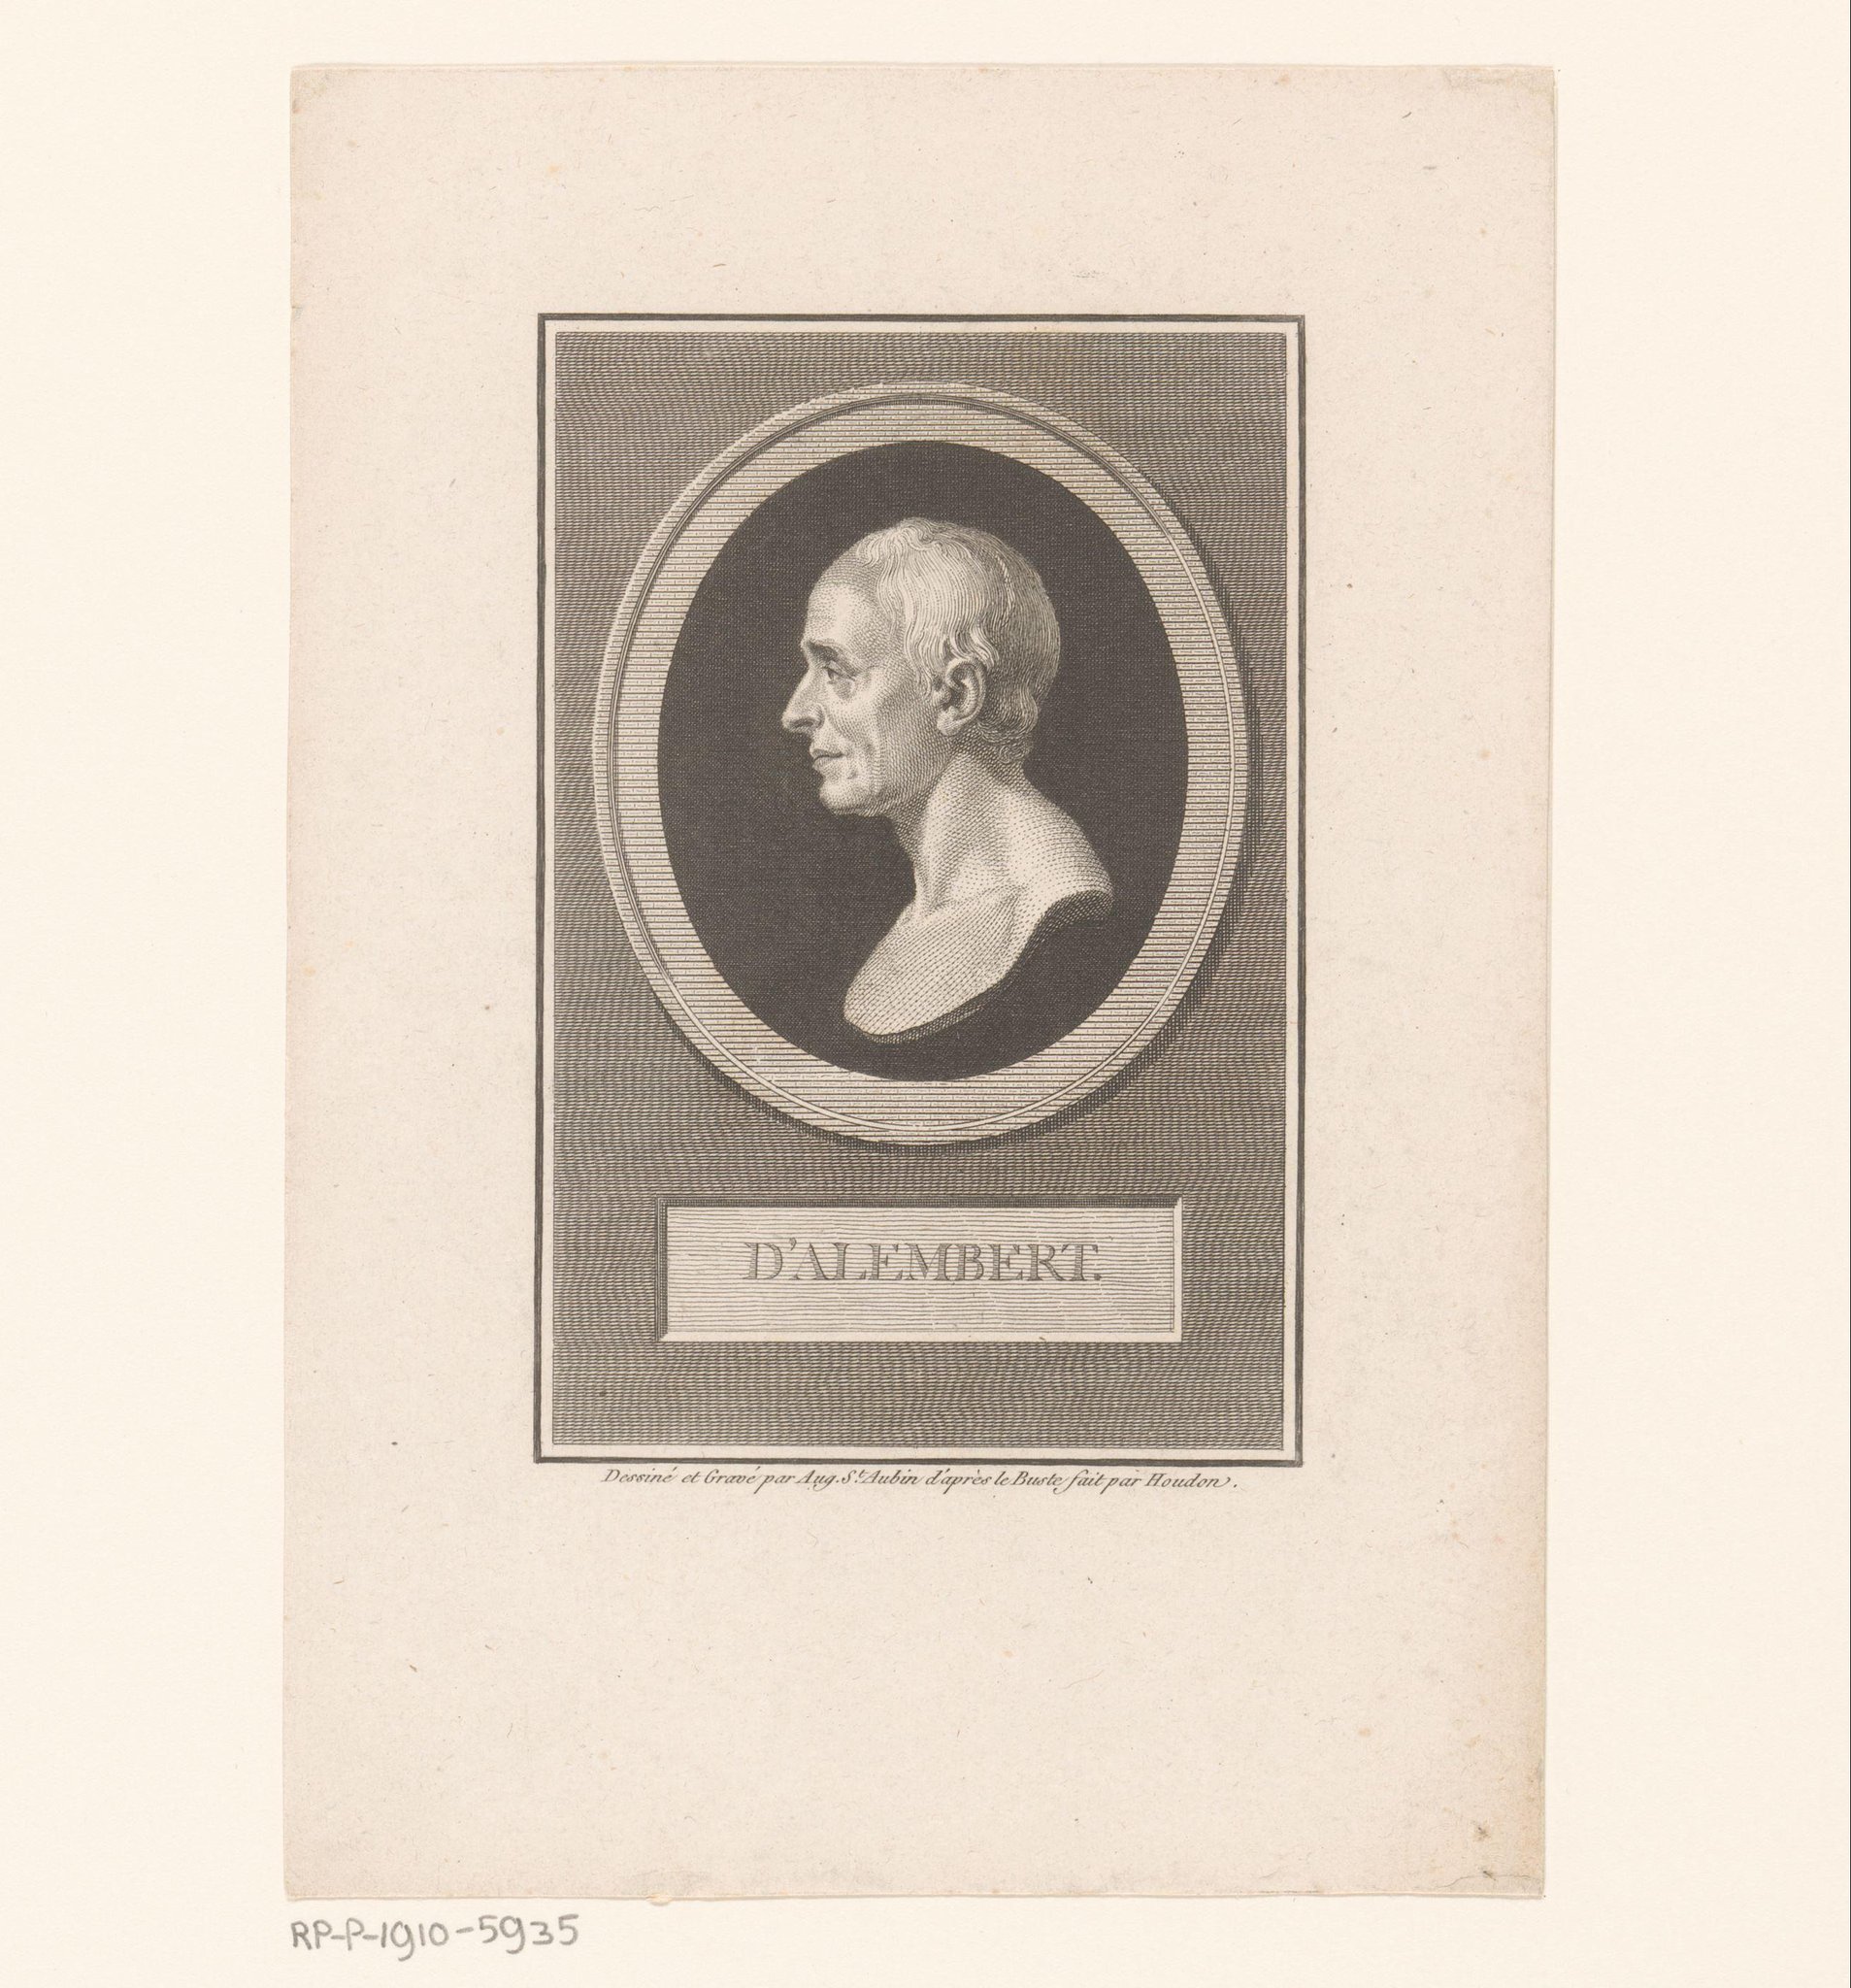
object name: print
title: Portret van Jean Le Rond d'Alembert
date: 1802-1807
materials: paper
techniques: engraving, etching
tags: scholar, philosopher, historical persons, mathematics (+ portrait of scholar, scientist)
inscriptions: collector's mark: Lugt 2228